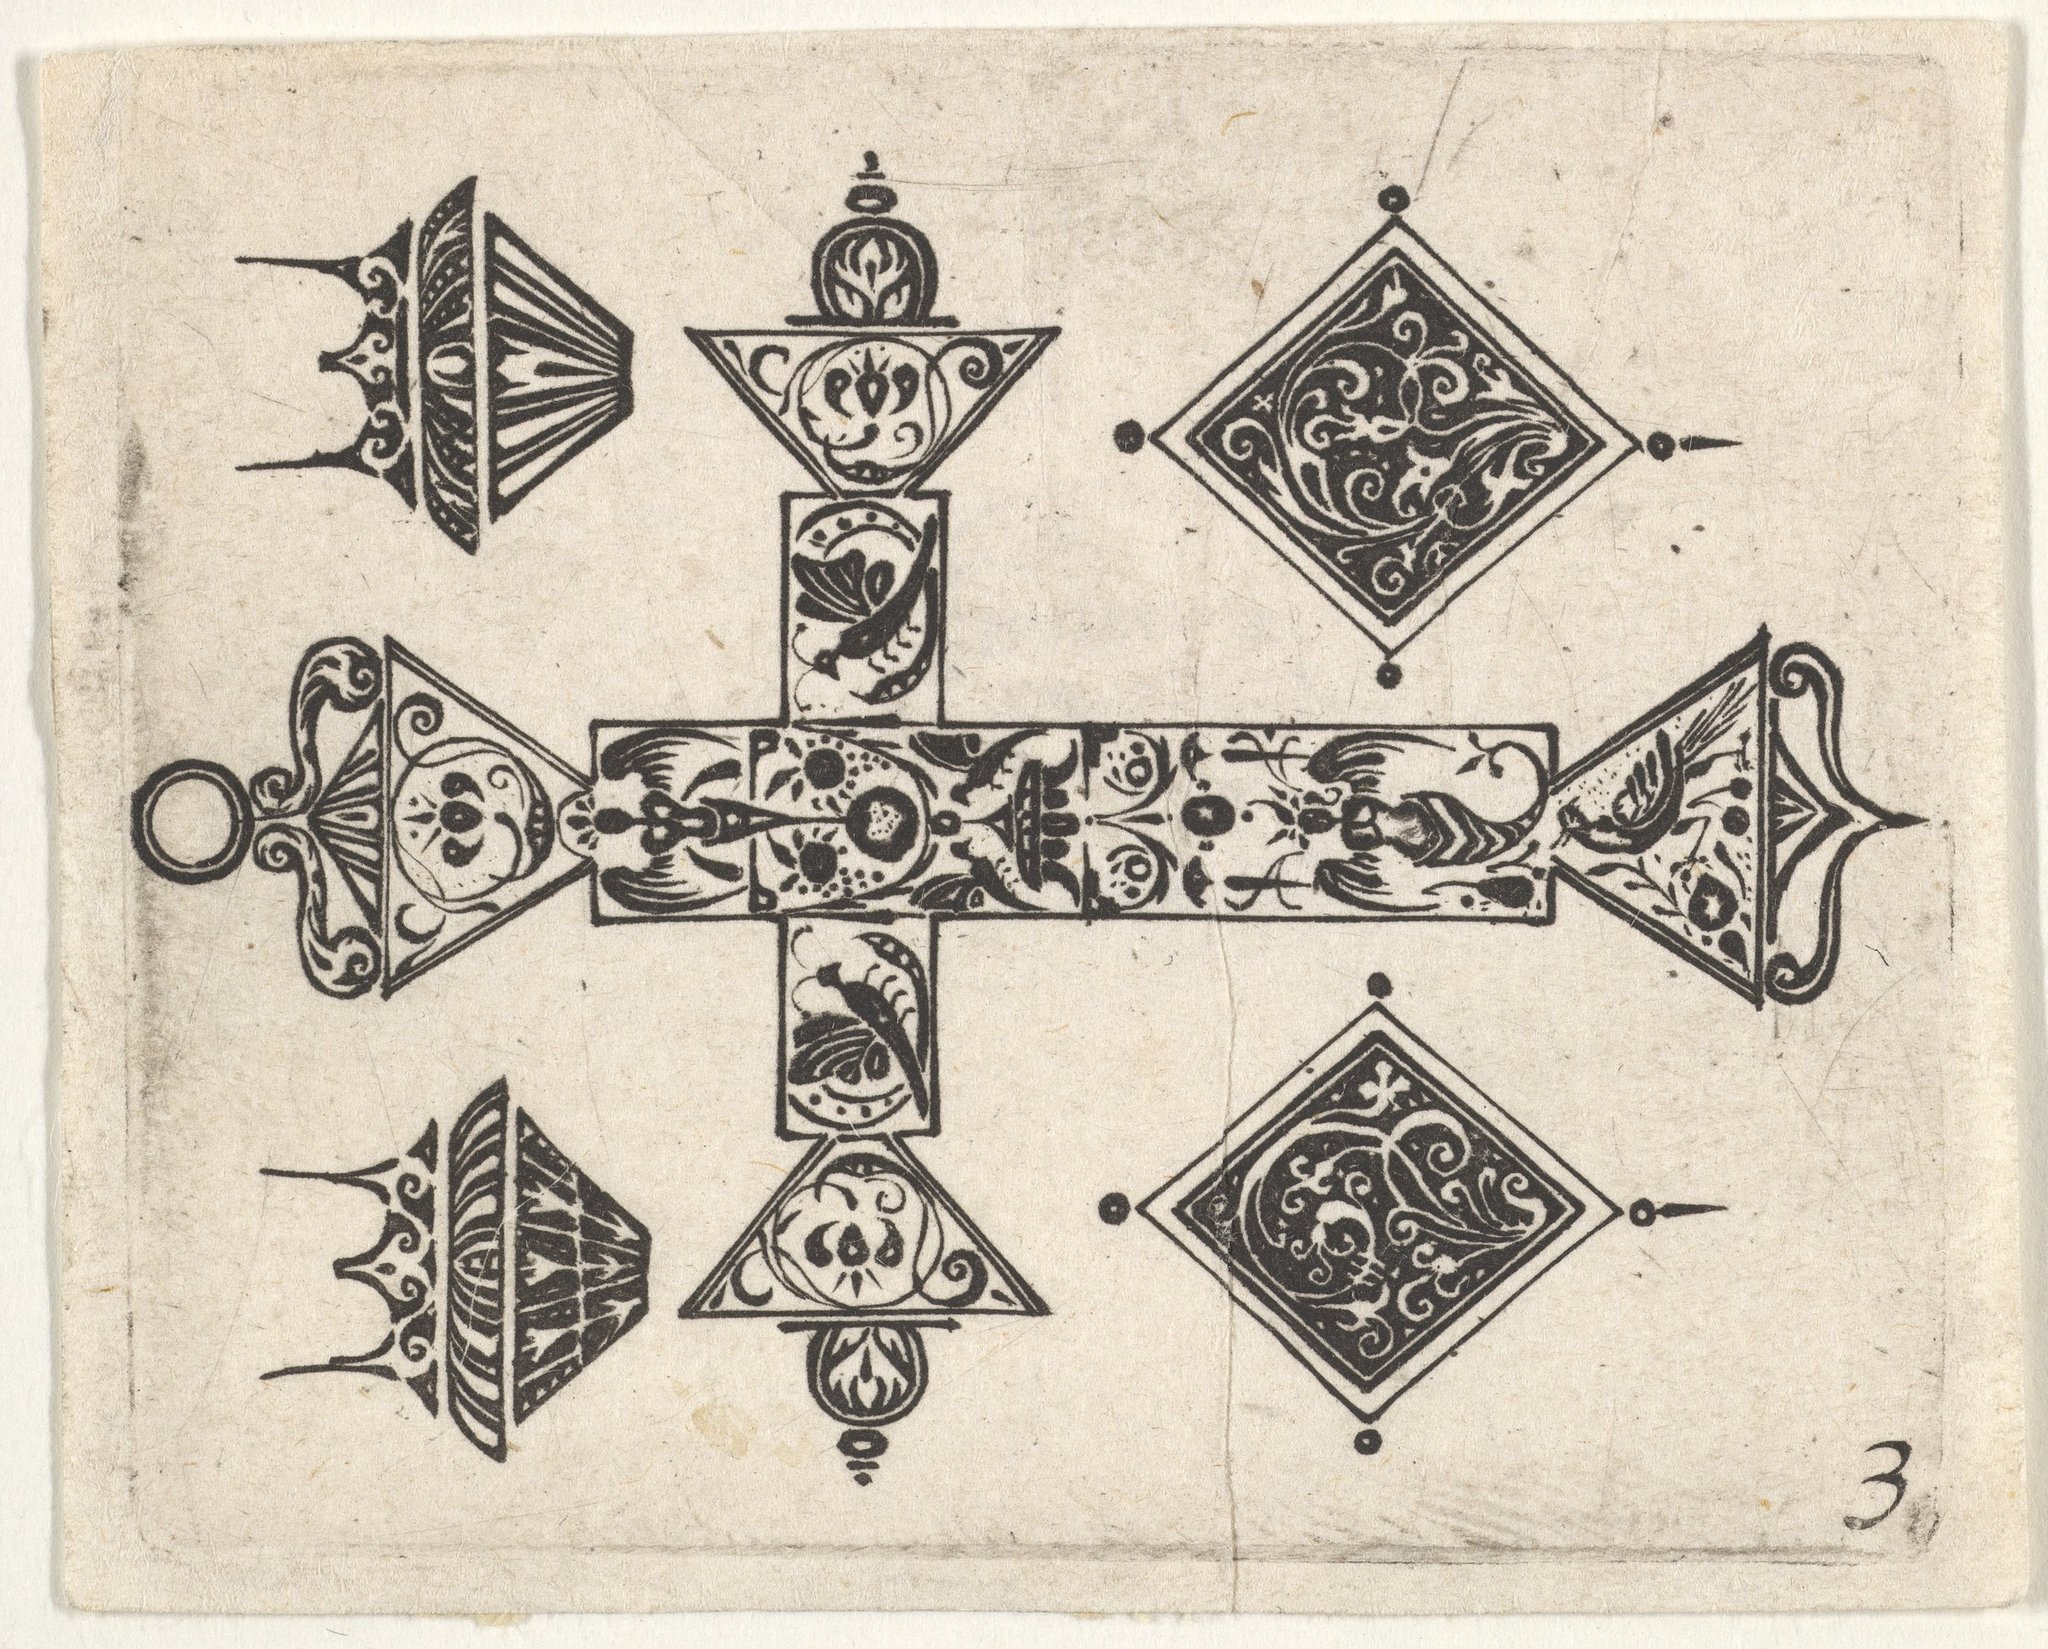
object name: print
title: Blackwork Print with a Latin Cross and Four Motifs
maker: claes jansz. visscher (ii)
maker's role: artist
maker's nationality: dutch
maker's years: 1586-1652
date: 1620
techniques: embroidery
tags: ornament